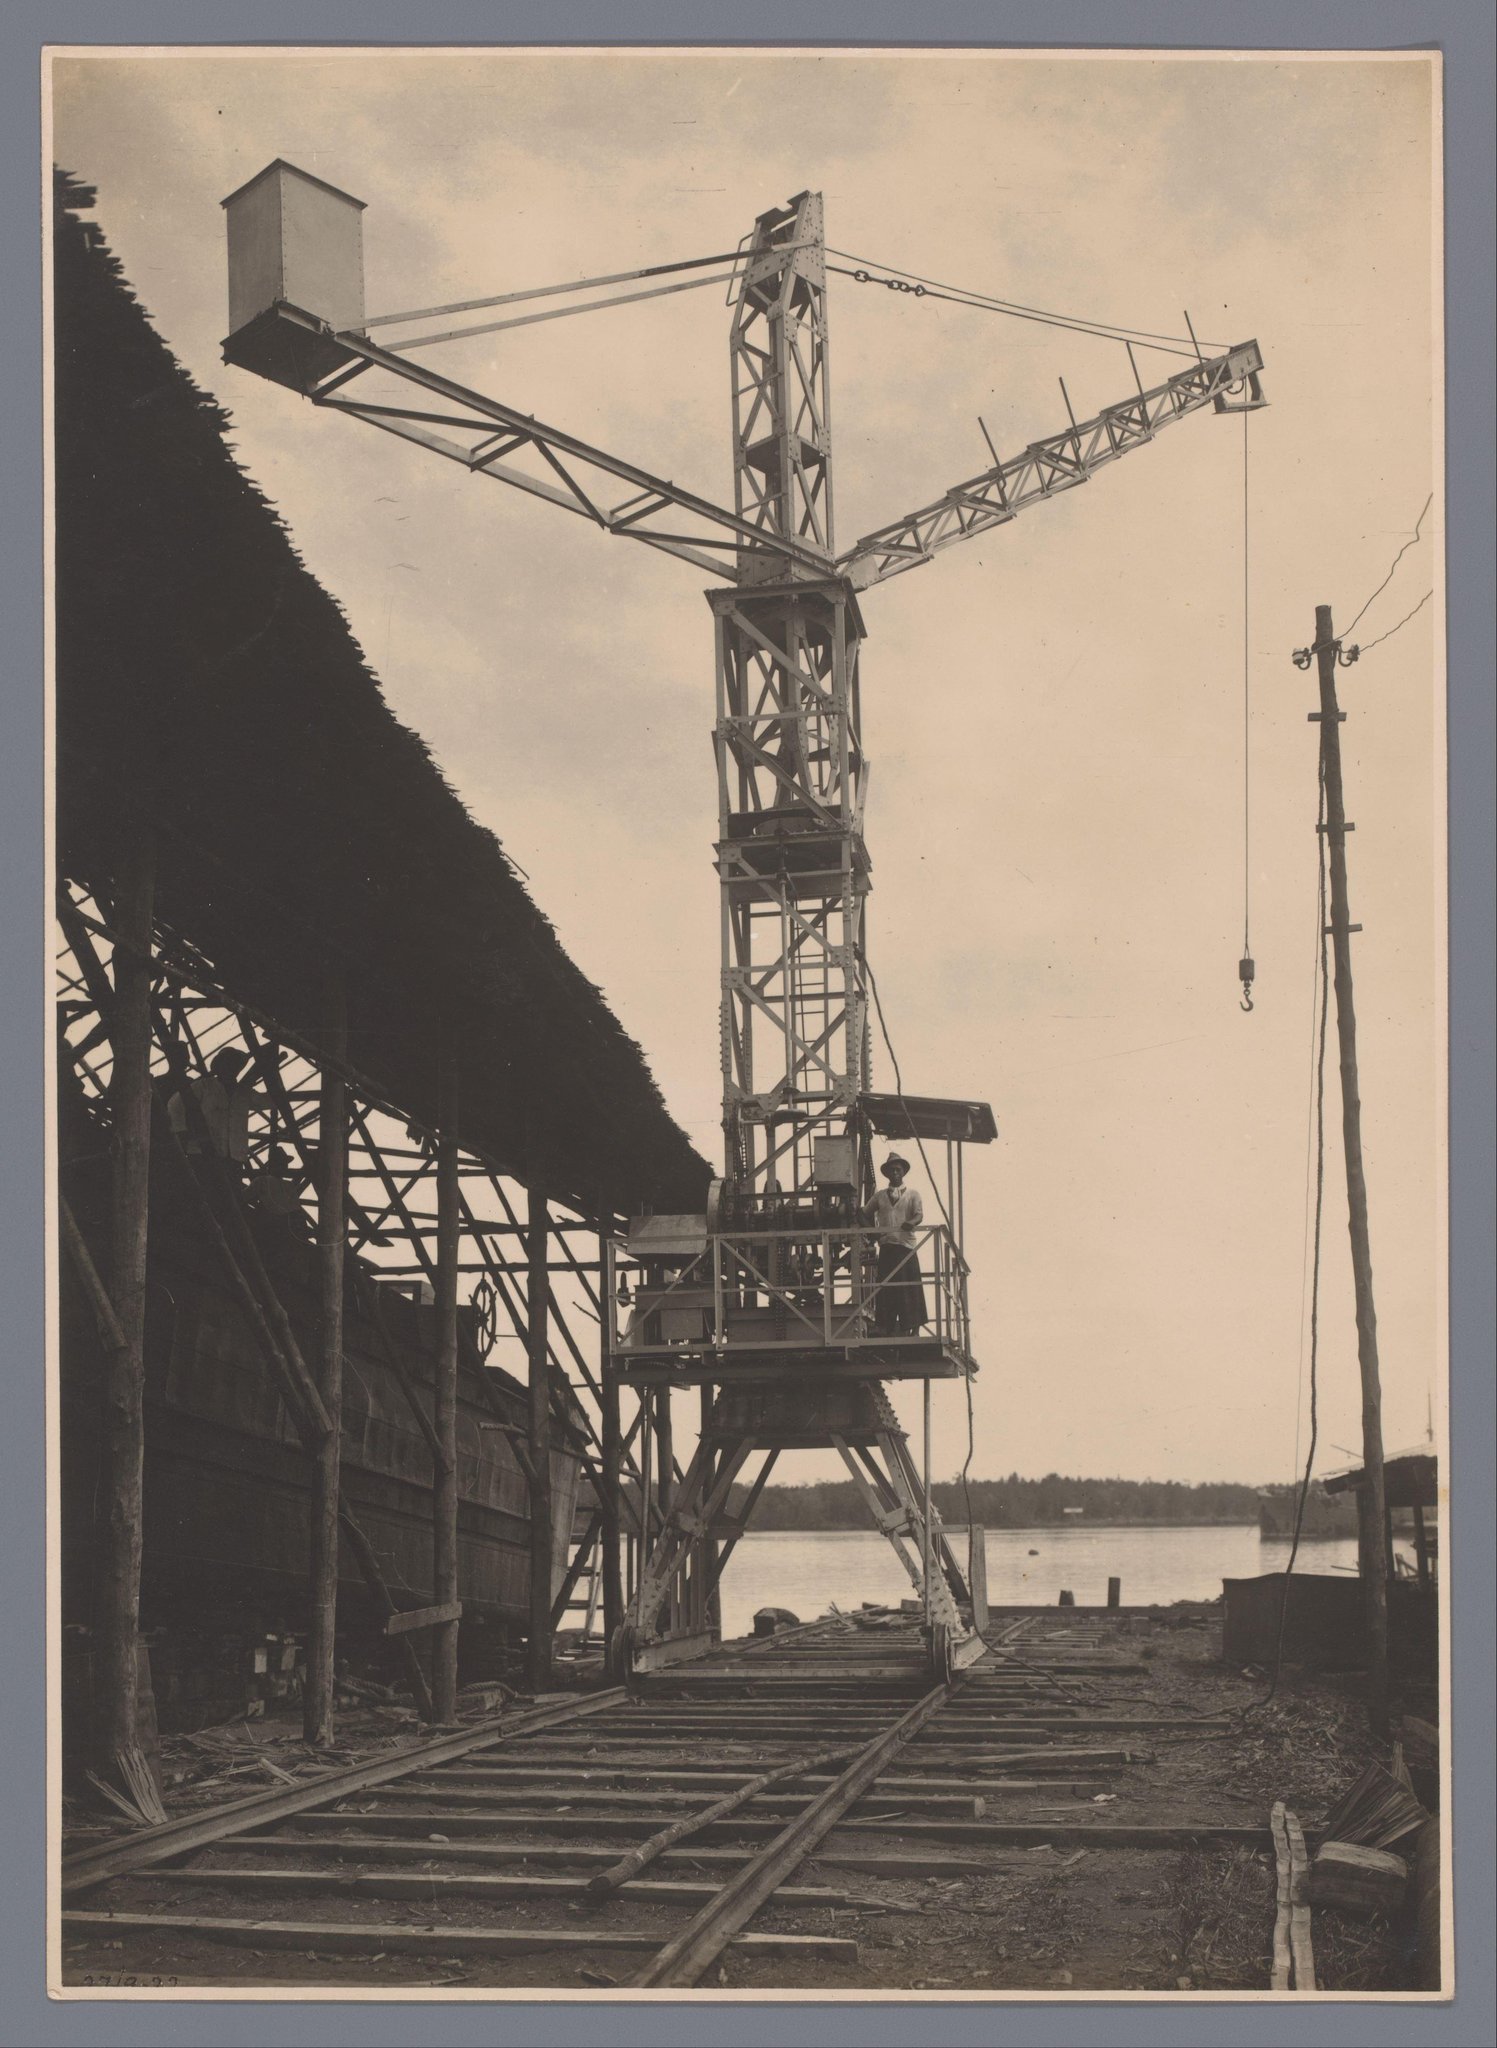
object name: photograph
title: Torenkraan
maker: Anonymous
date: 1922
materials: photographic support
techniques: gelatin silver print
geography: belawan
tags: harbour, dock crane, building-site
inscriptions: inscription: ‘No. 222 / Torenkraan’, date: ‘27/9 22’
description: Verrijdbare hijskraan op rails, op het bouwterrein, september 1922. Op de kraan staat de kraandrijver. Genummerd: 222. Onderdeel van de groep van losse foto's over de aanleg van de haven Belawan aan de kust voor Medan, Sumatra 1921-1922.